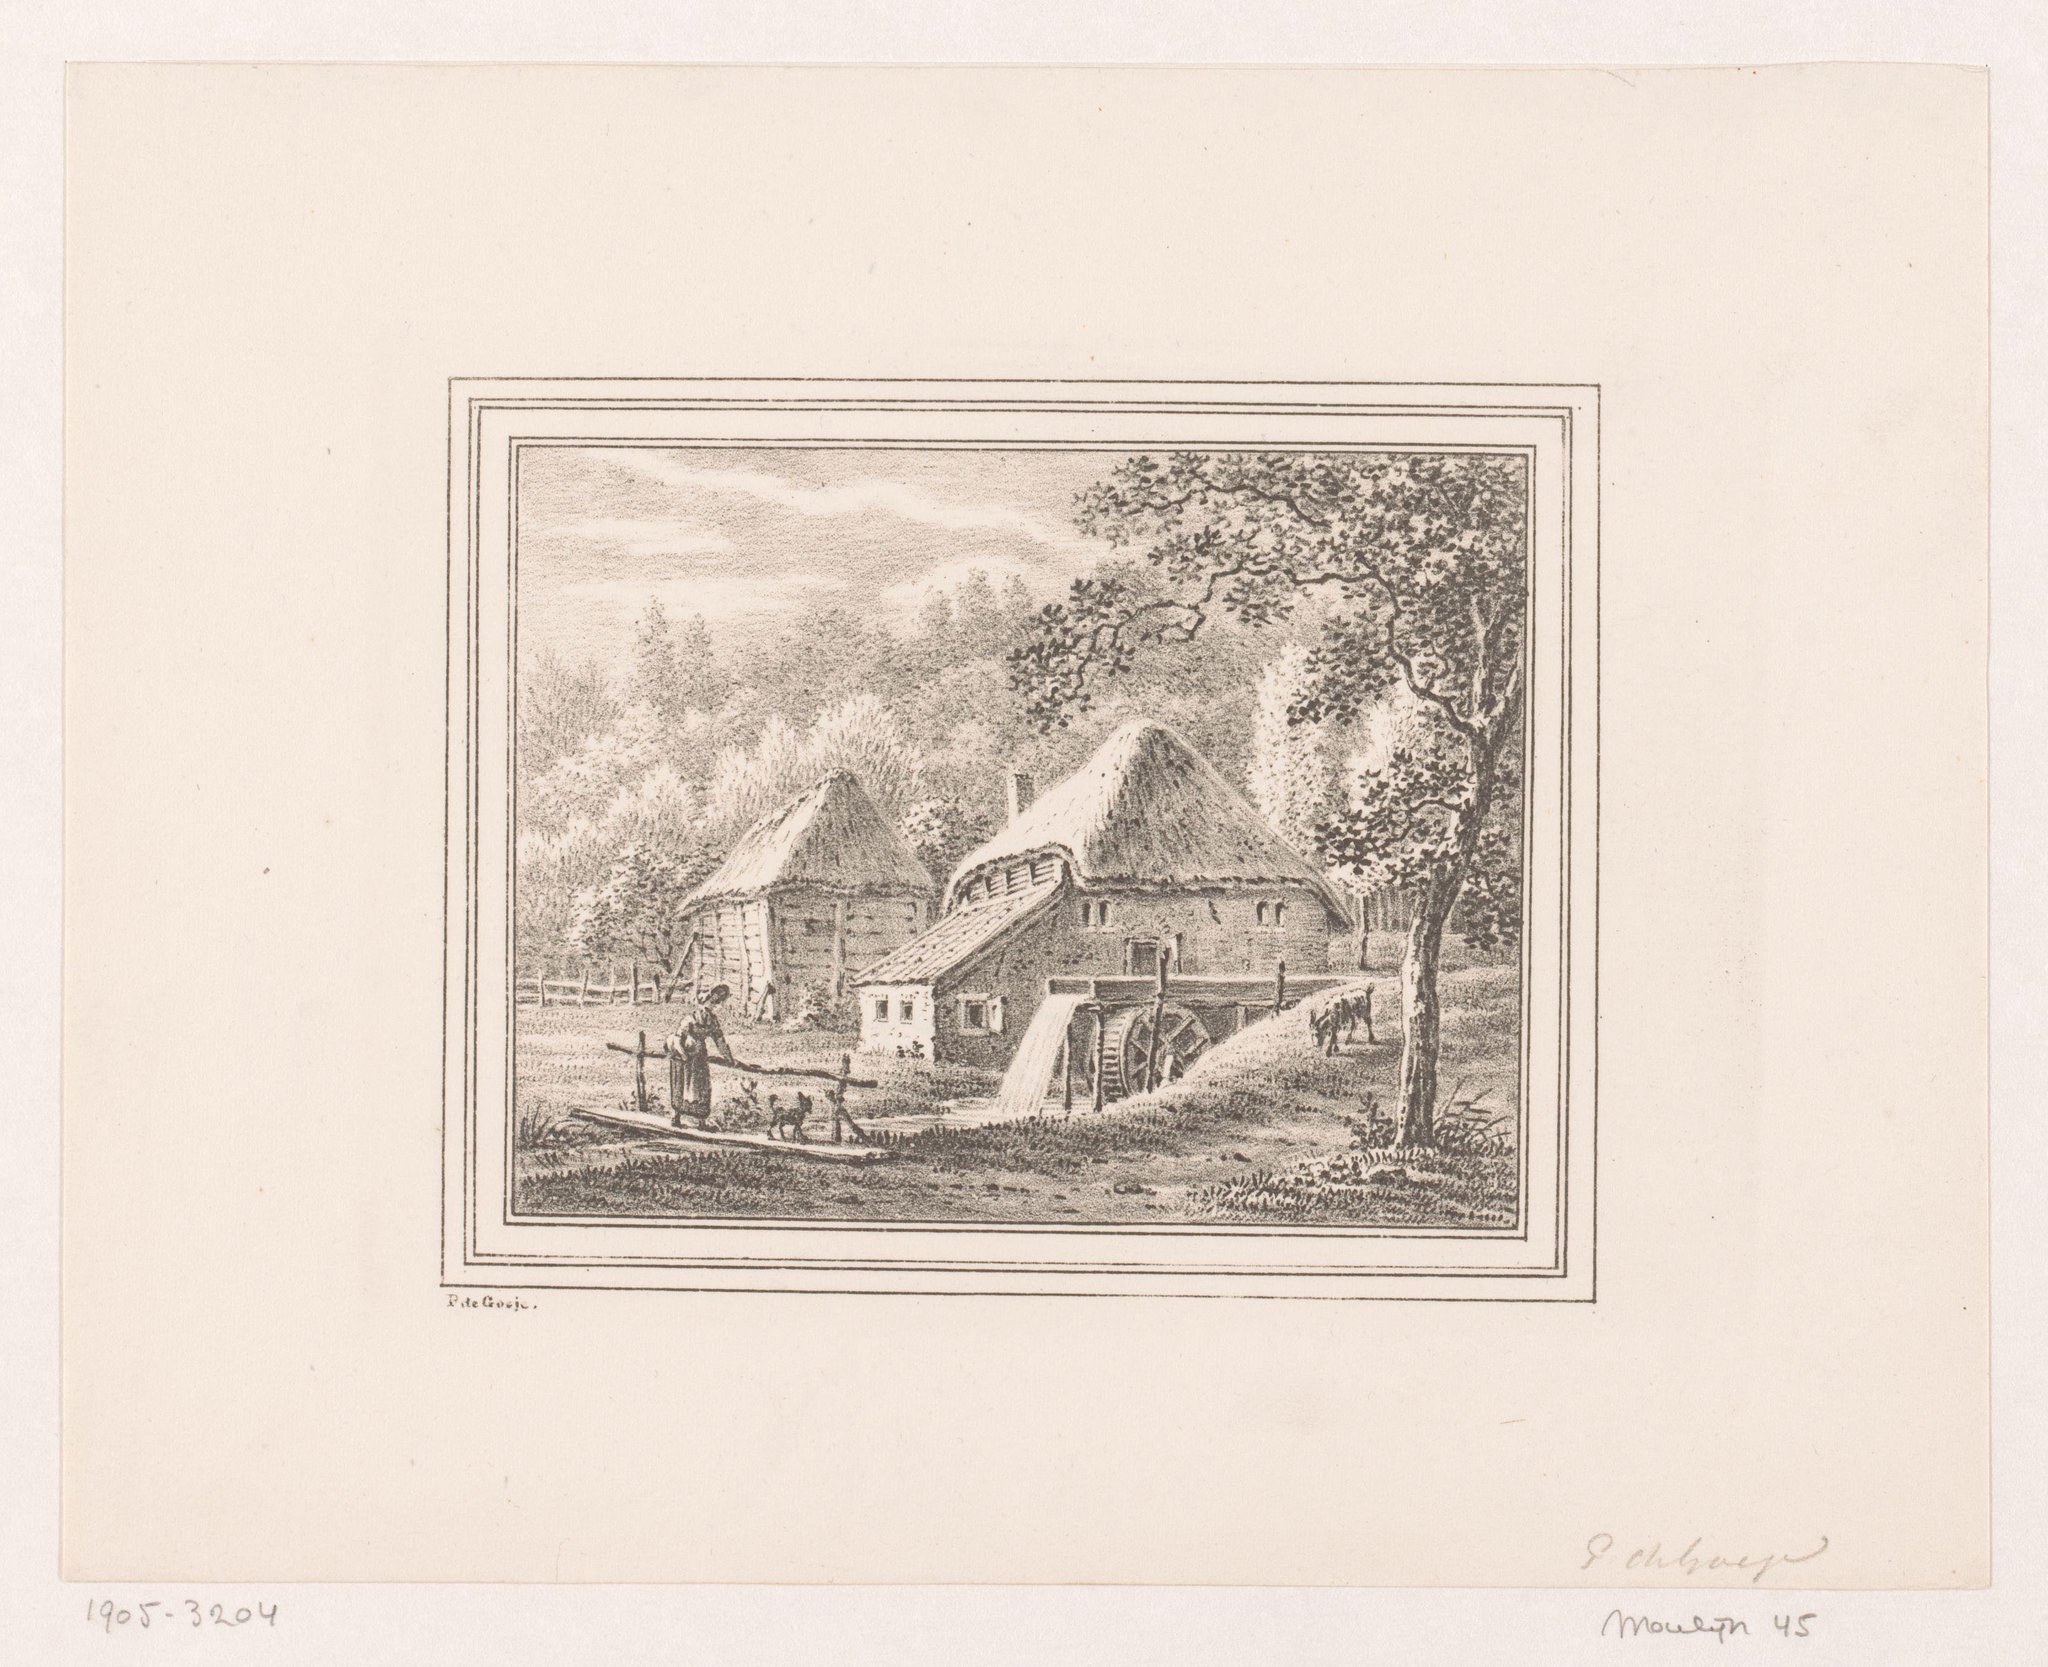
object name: print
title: Landschap met watermolen en schuur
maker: pieter de goeje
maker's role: draughtsman, print maker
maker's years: 1789-1859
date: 1825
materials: paper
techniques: lithograph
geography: netherlands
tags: landscape with bridge, viaduct or aqueduct, watermill in landscape, goat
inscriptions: collector's mark: Lugt 2228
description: Over het water loopt een brug met daarop een vrouw en een hond. Rechts een boom en een geit.